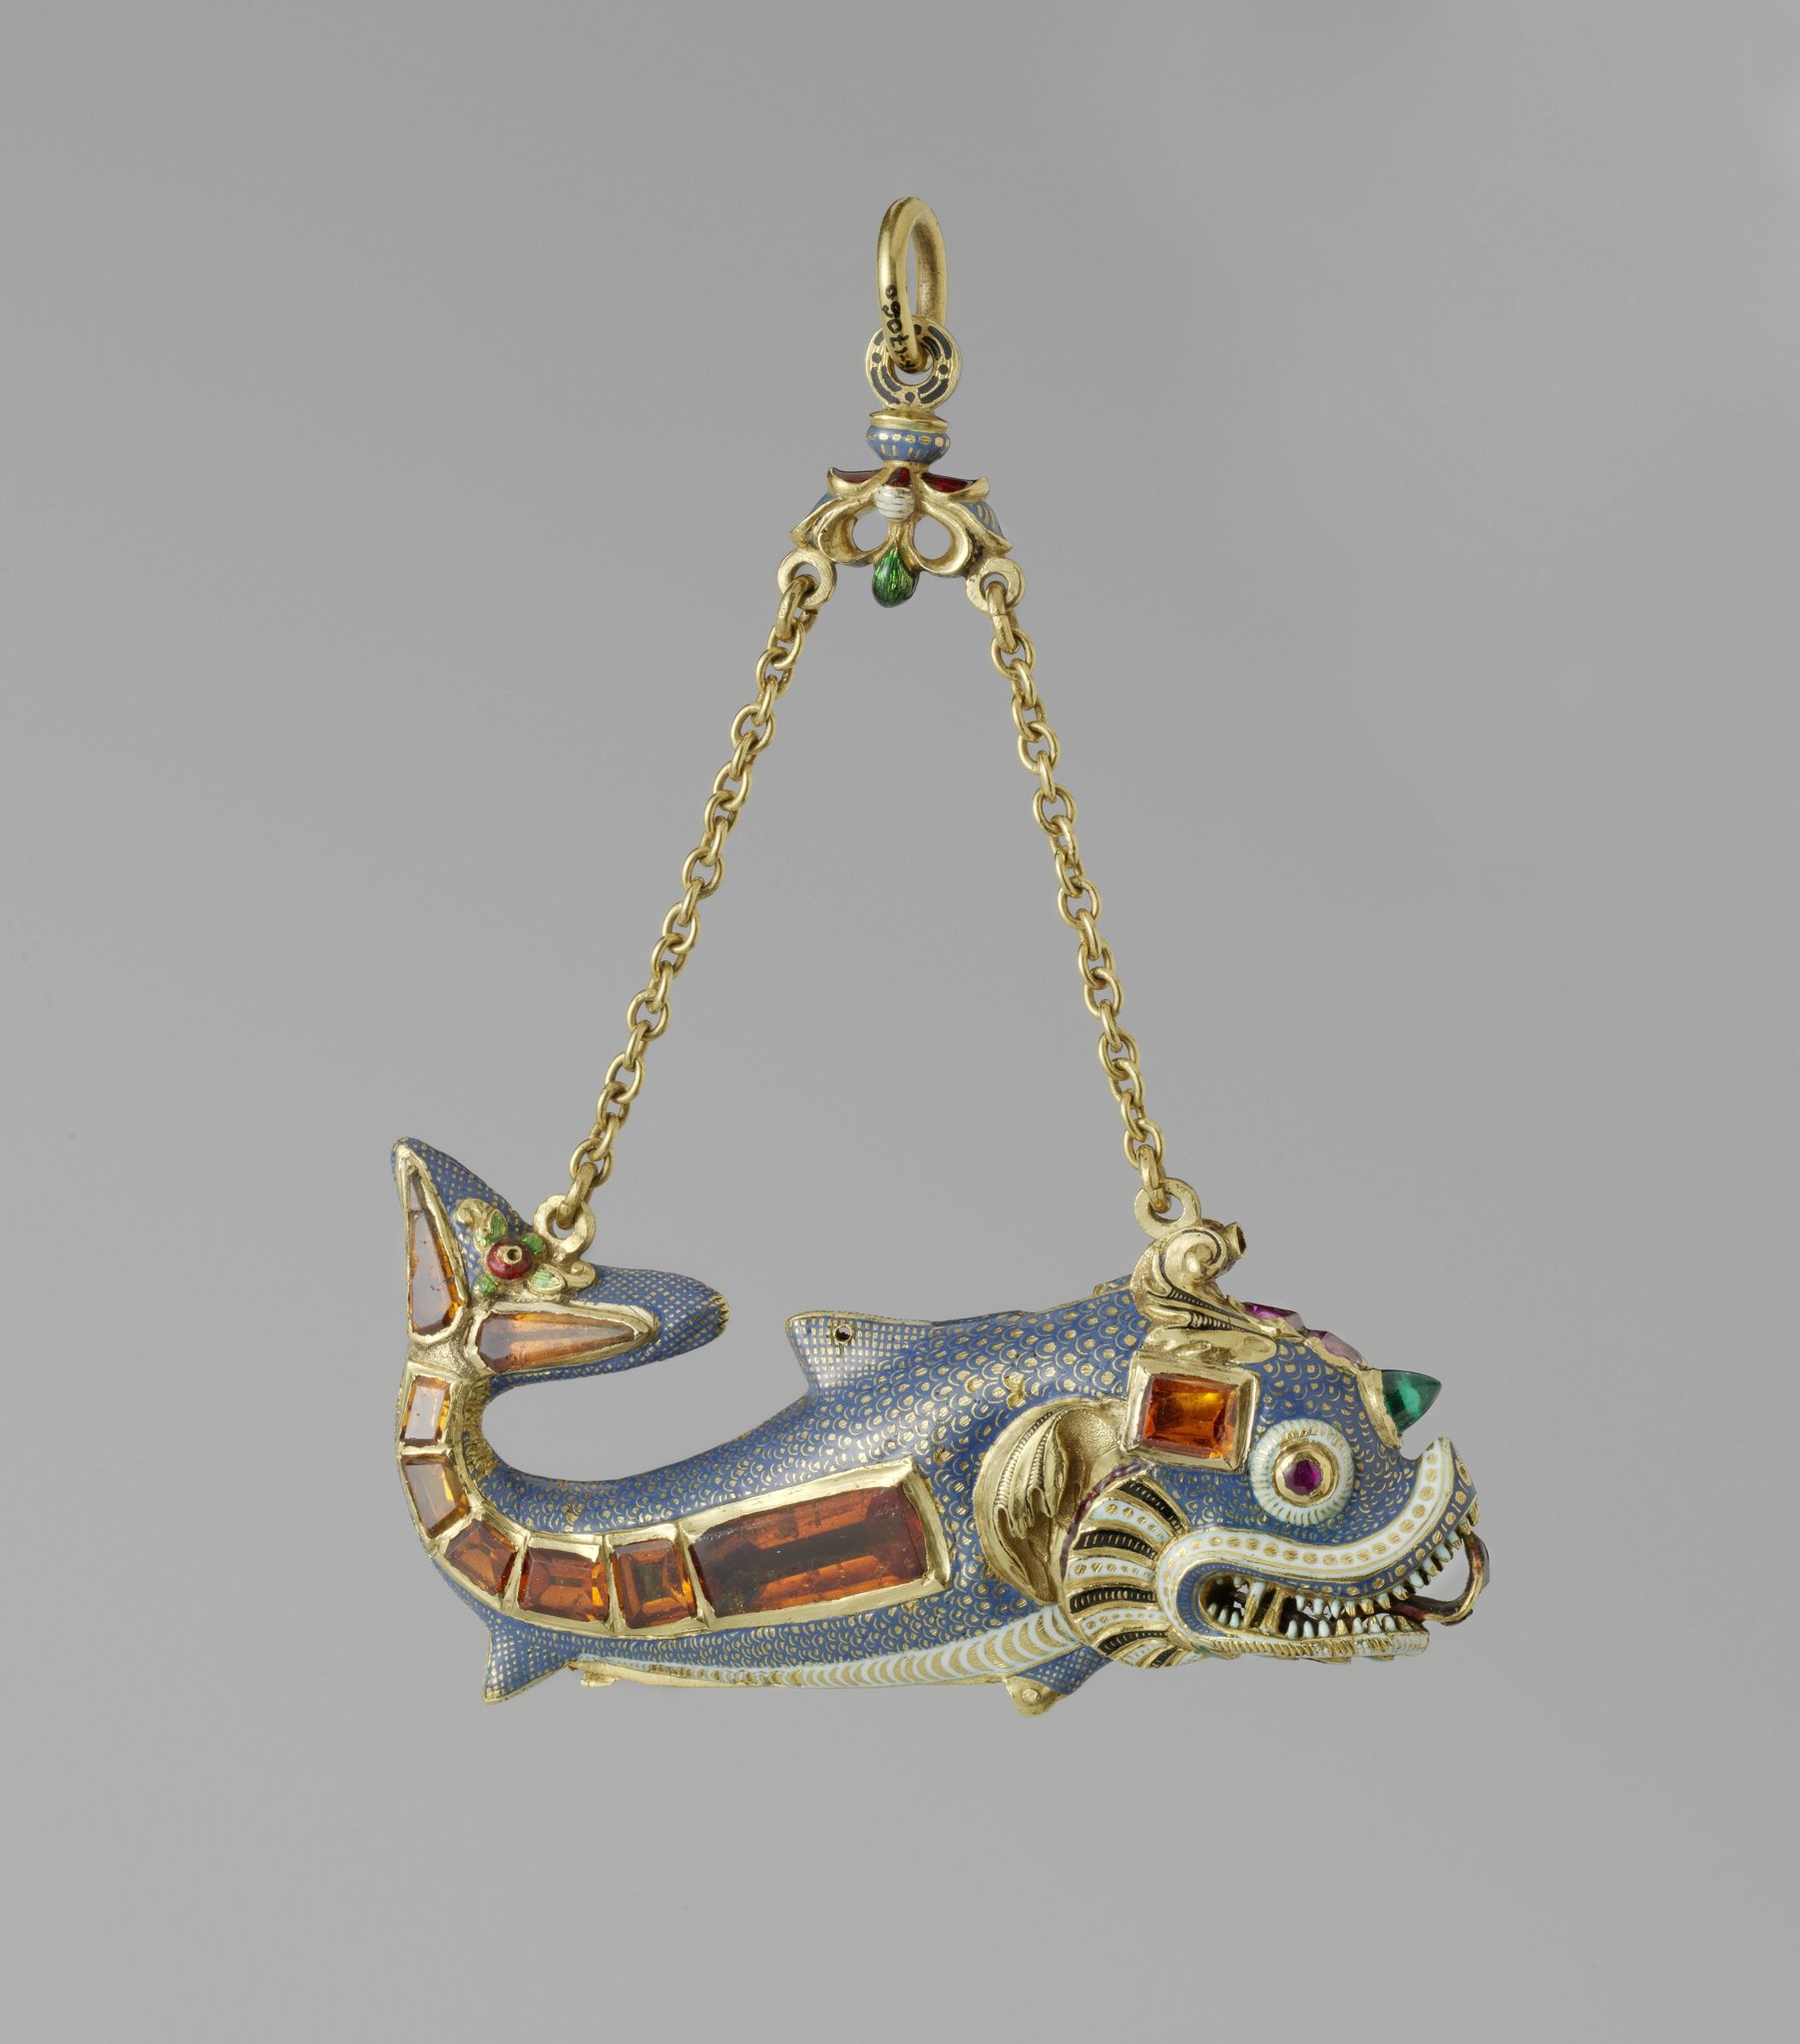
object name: pendant jewelry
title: Hanger en necessaire in de vorm van een dolfijn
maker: Anonymous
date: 1600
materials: gemstone, gold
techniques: enameling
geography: germany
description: Pendant, dolphin. Gold, emerald, topaz and enamel. Germany or Spain, c. 1600.